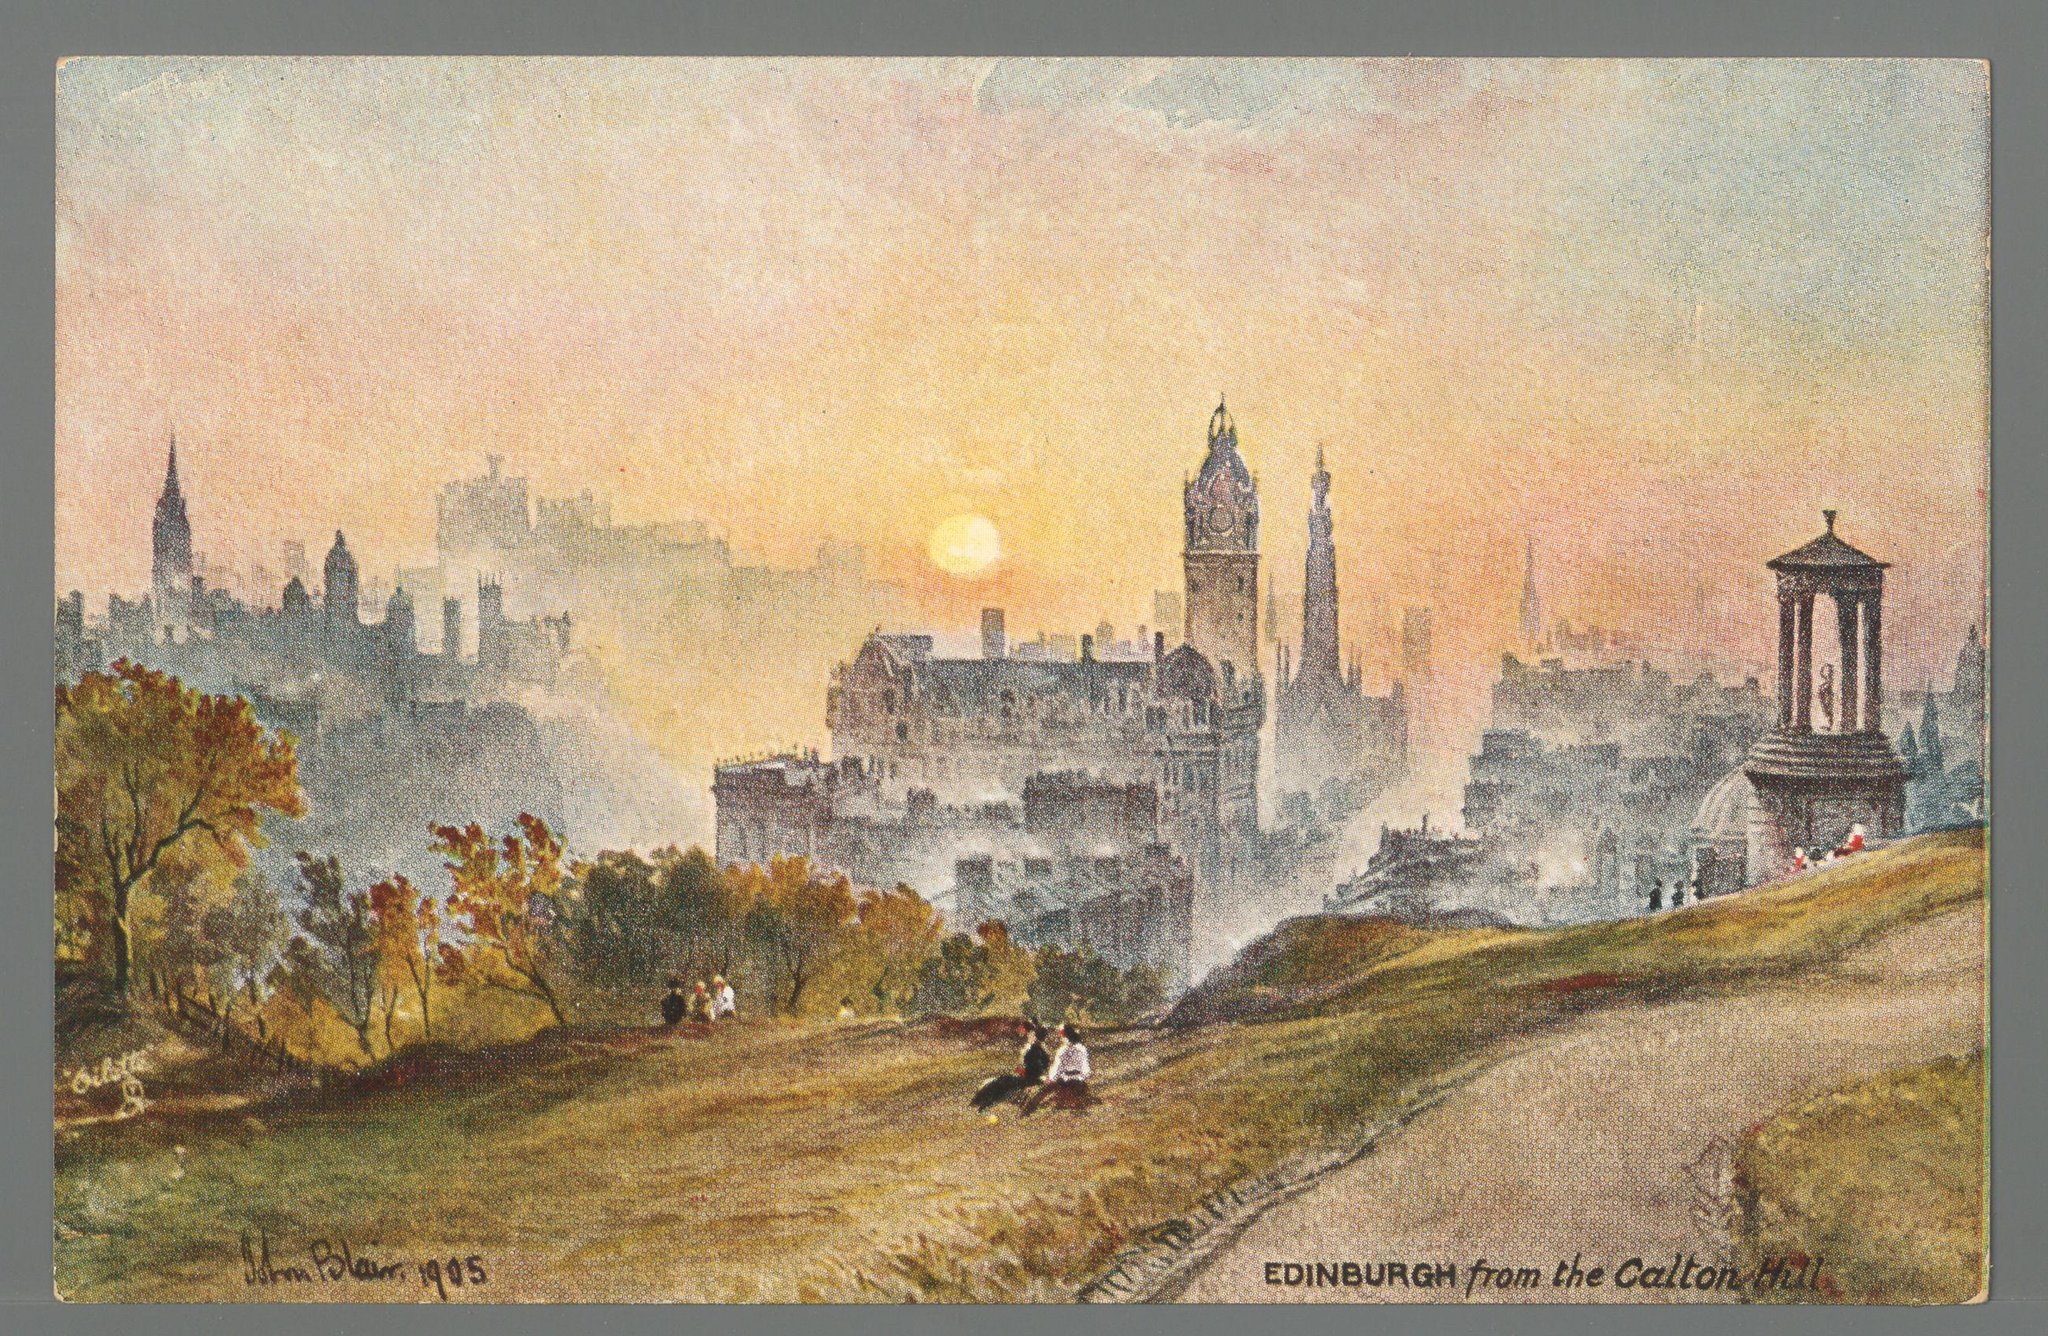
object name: reproduction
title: Edinburgh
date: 1905-1912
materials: cardboard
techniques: color autotype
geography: london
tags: (high) hill